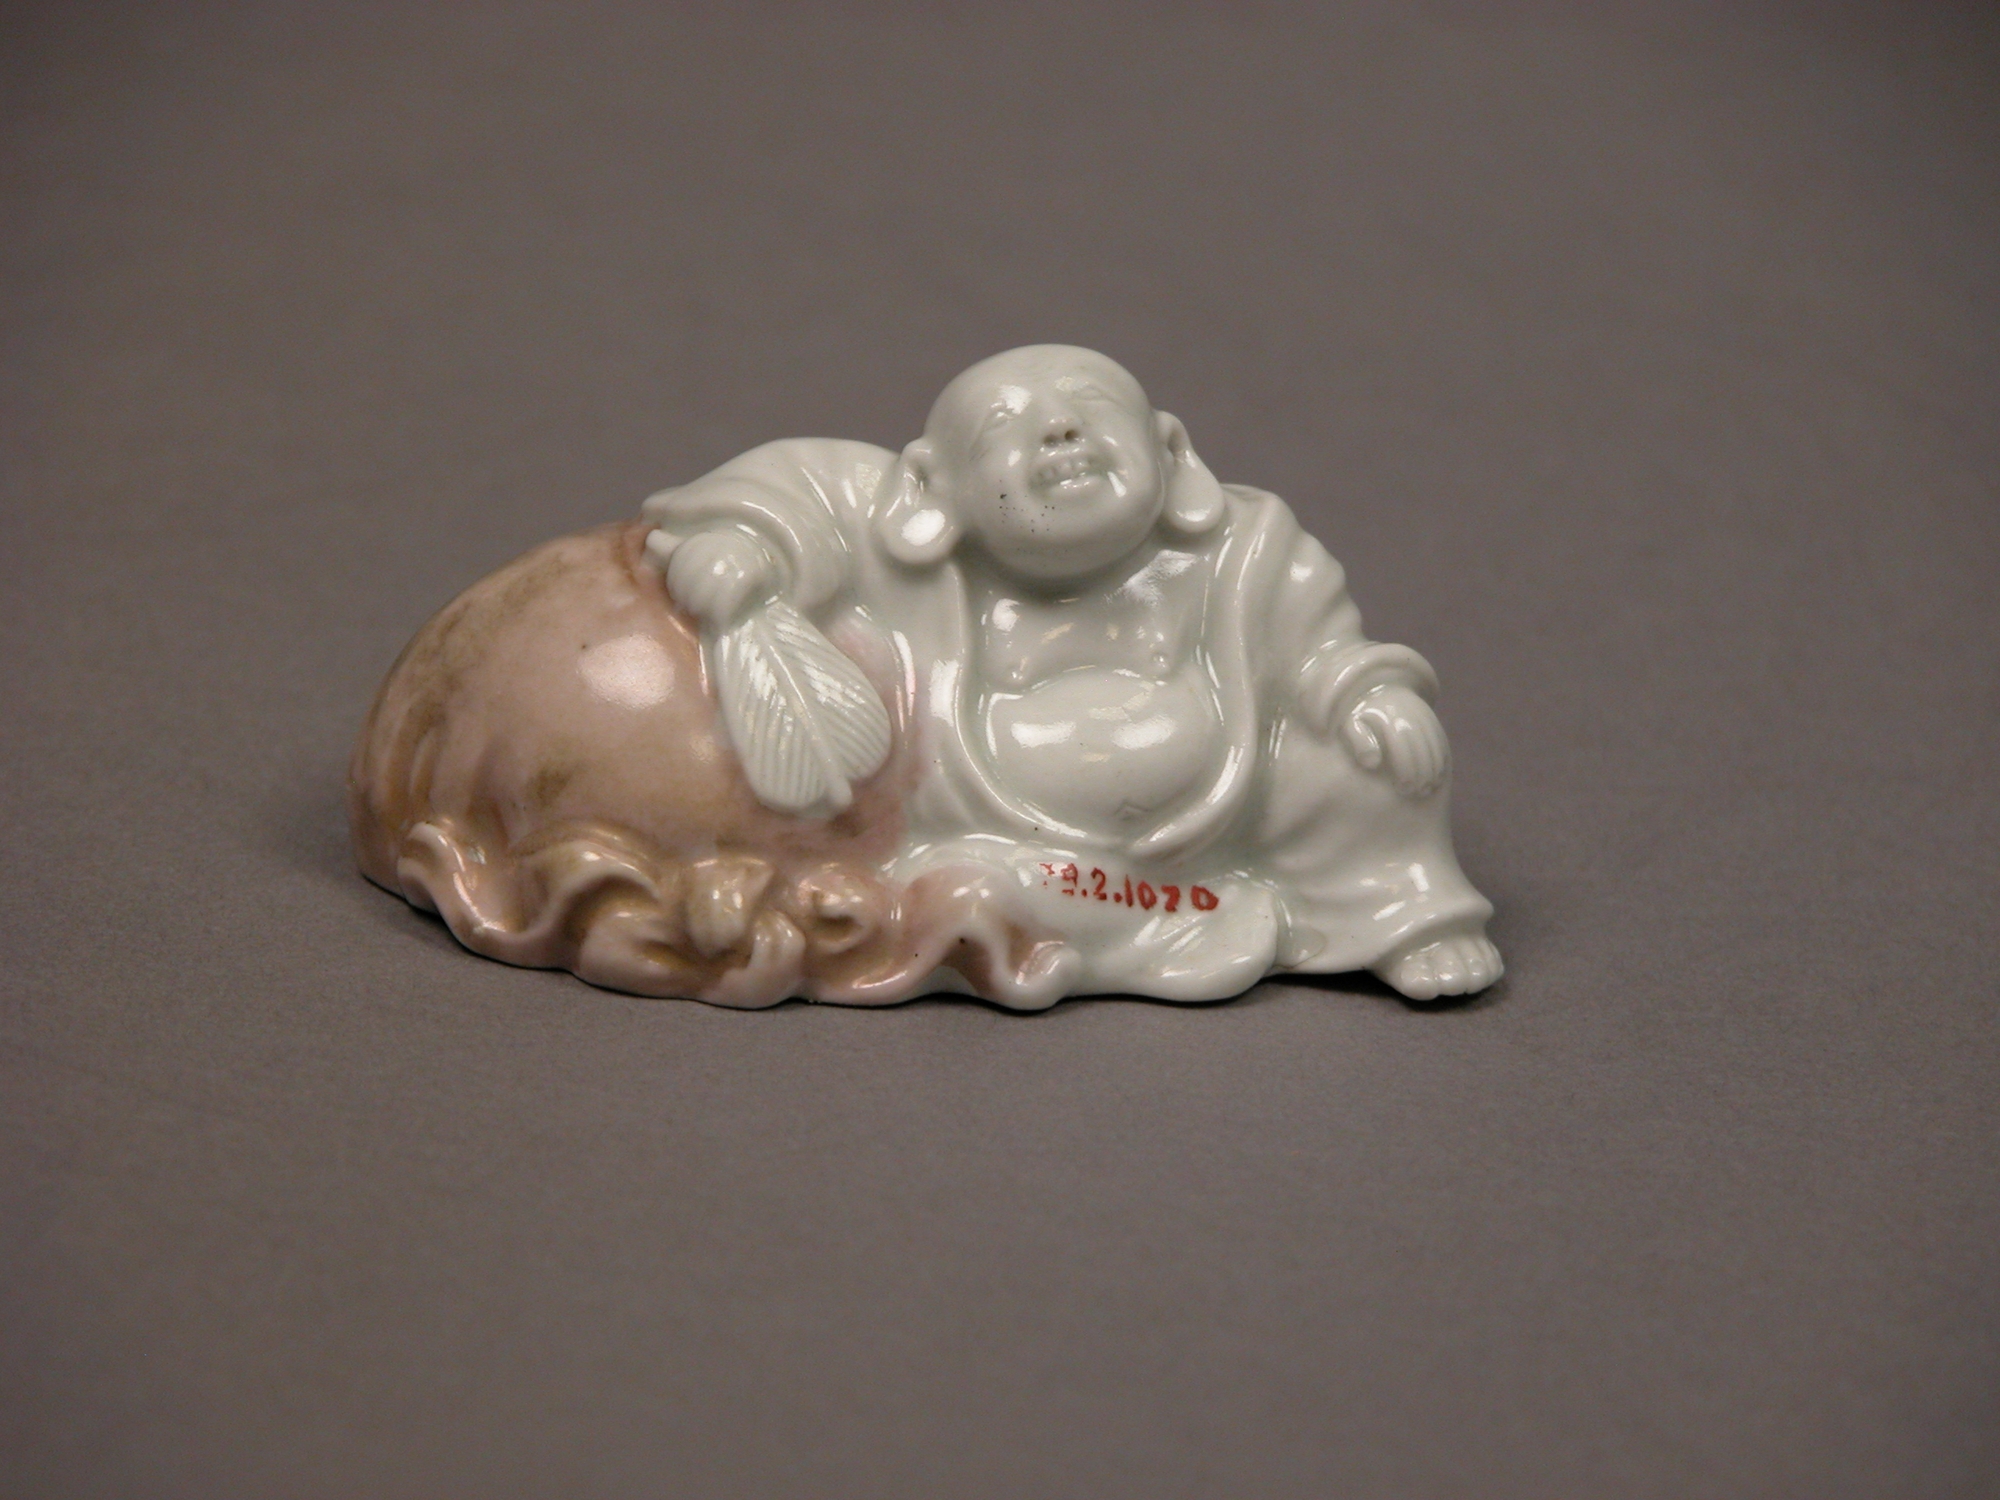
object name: figure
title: Figure of Hotei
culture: japanese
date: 1701-1800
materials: porcelain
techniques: glazing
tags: men